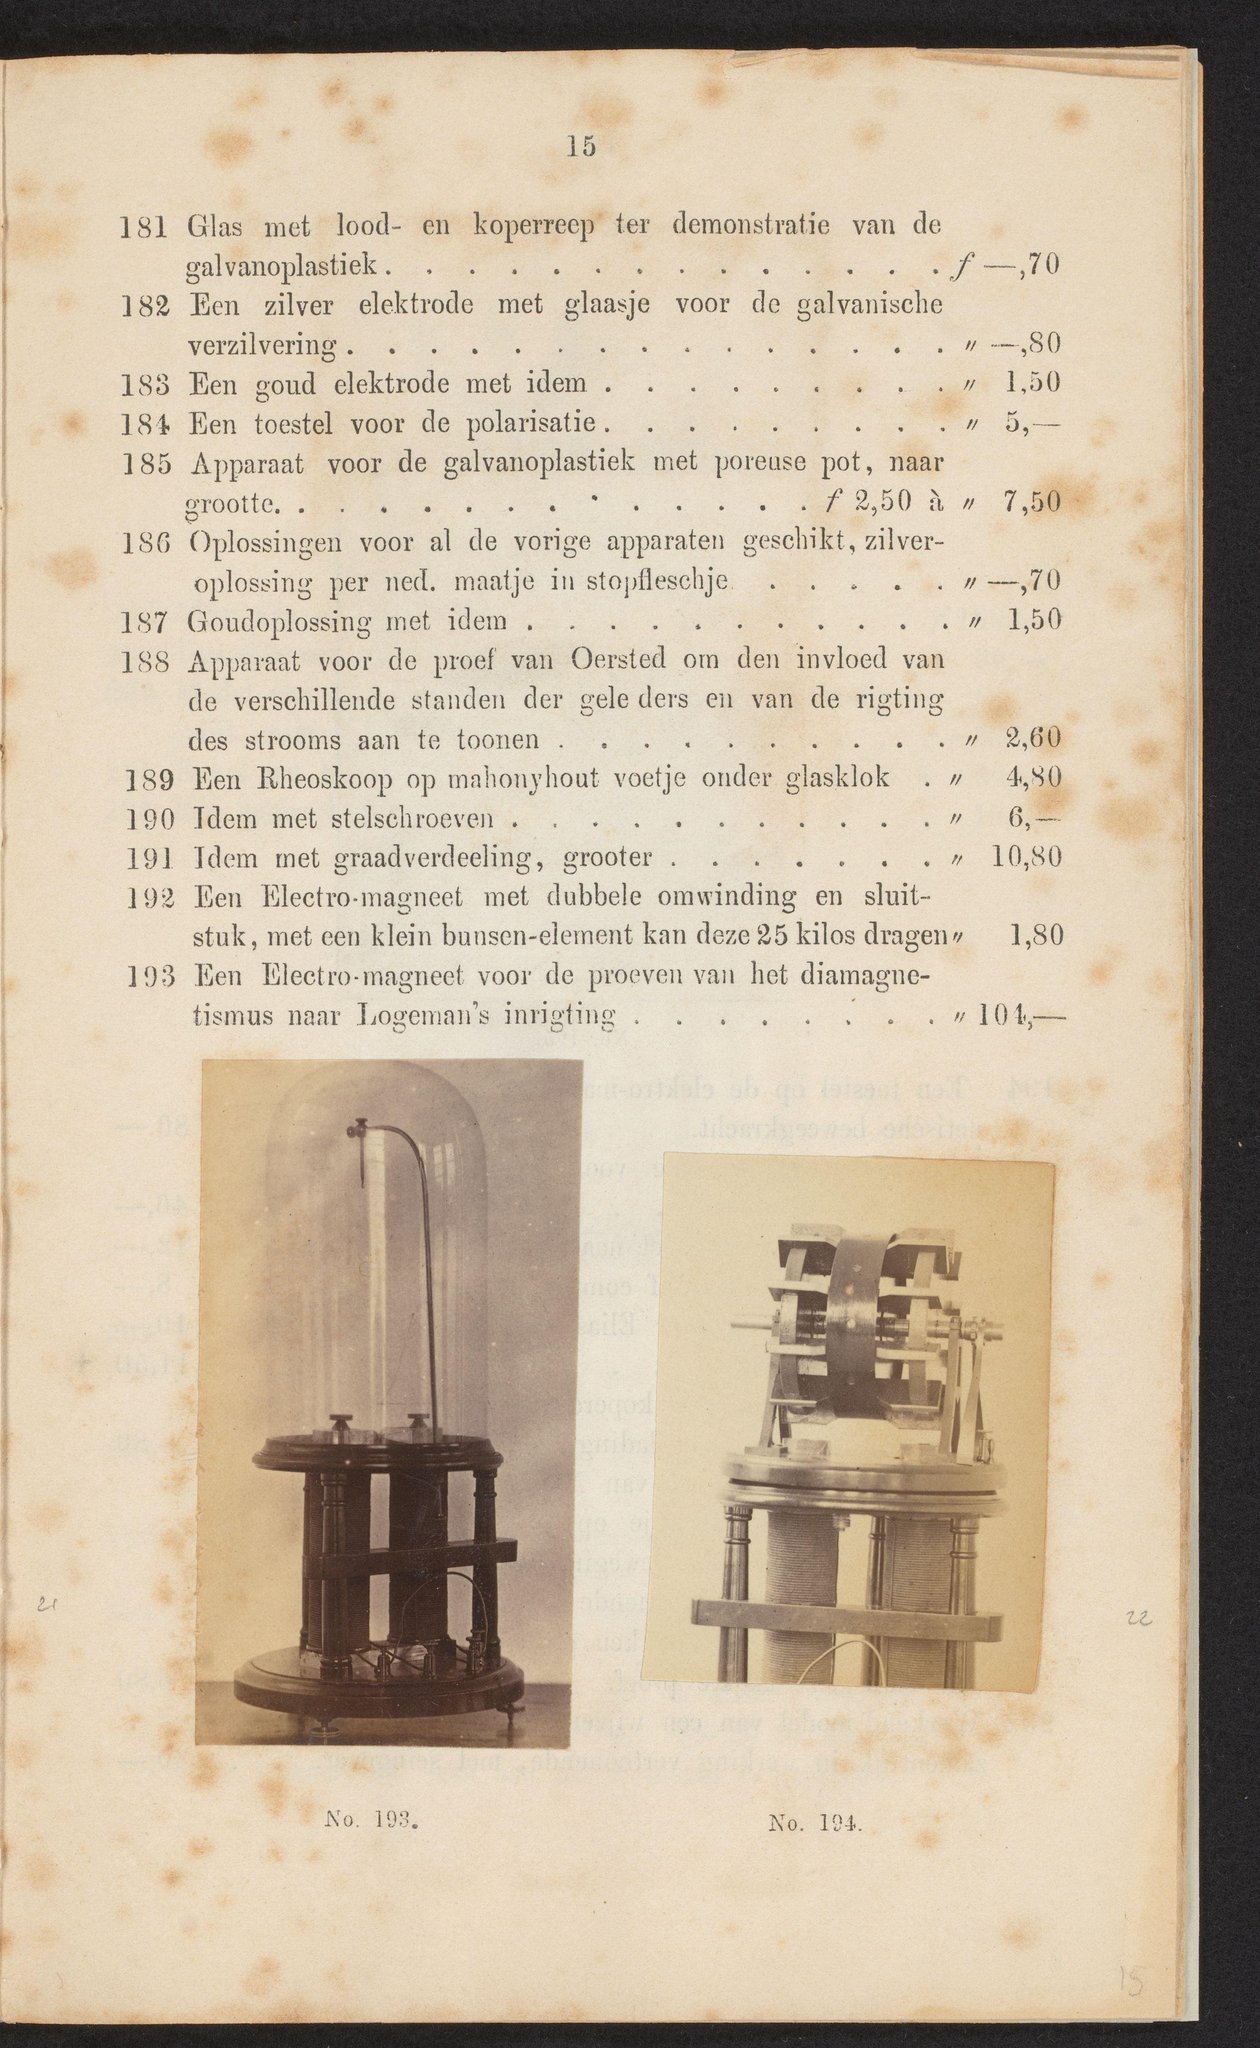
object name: page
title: Twee afbeeldingen van een elektromagneet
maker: fredrich wilhelm funckler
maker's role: instrument maker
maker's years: 1836-1886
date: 1857-1867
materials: paper, photographic support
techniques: albumen print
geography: netherlands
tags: physics (+ tools, instruments; laboratory equipment ~ scientific research)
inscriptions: number: ‘No. 193., No. 194.’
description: Links een elektromagneet, rechts een toestel op een elektromagneet.